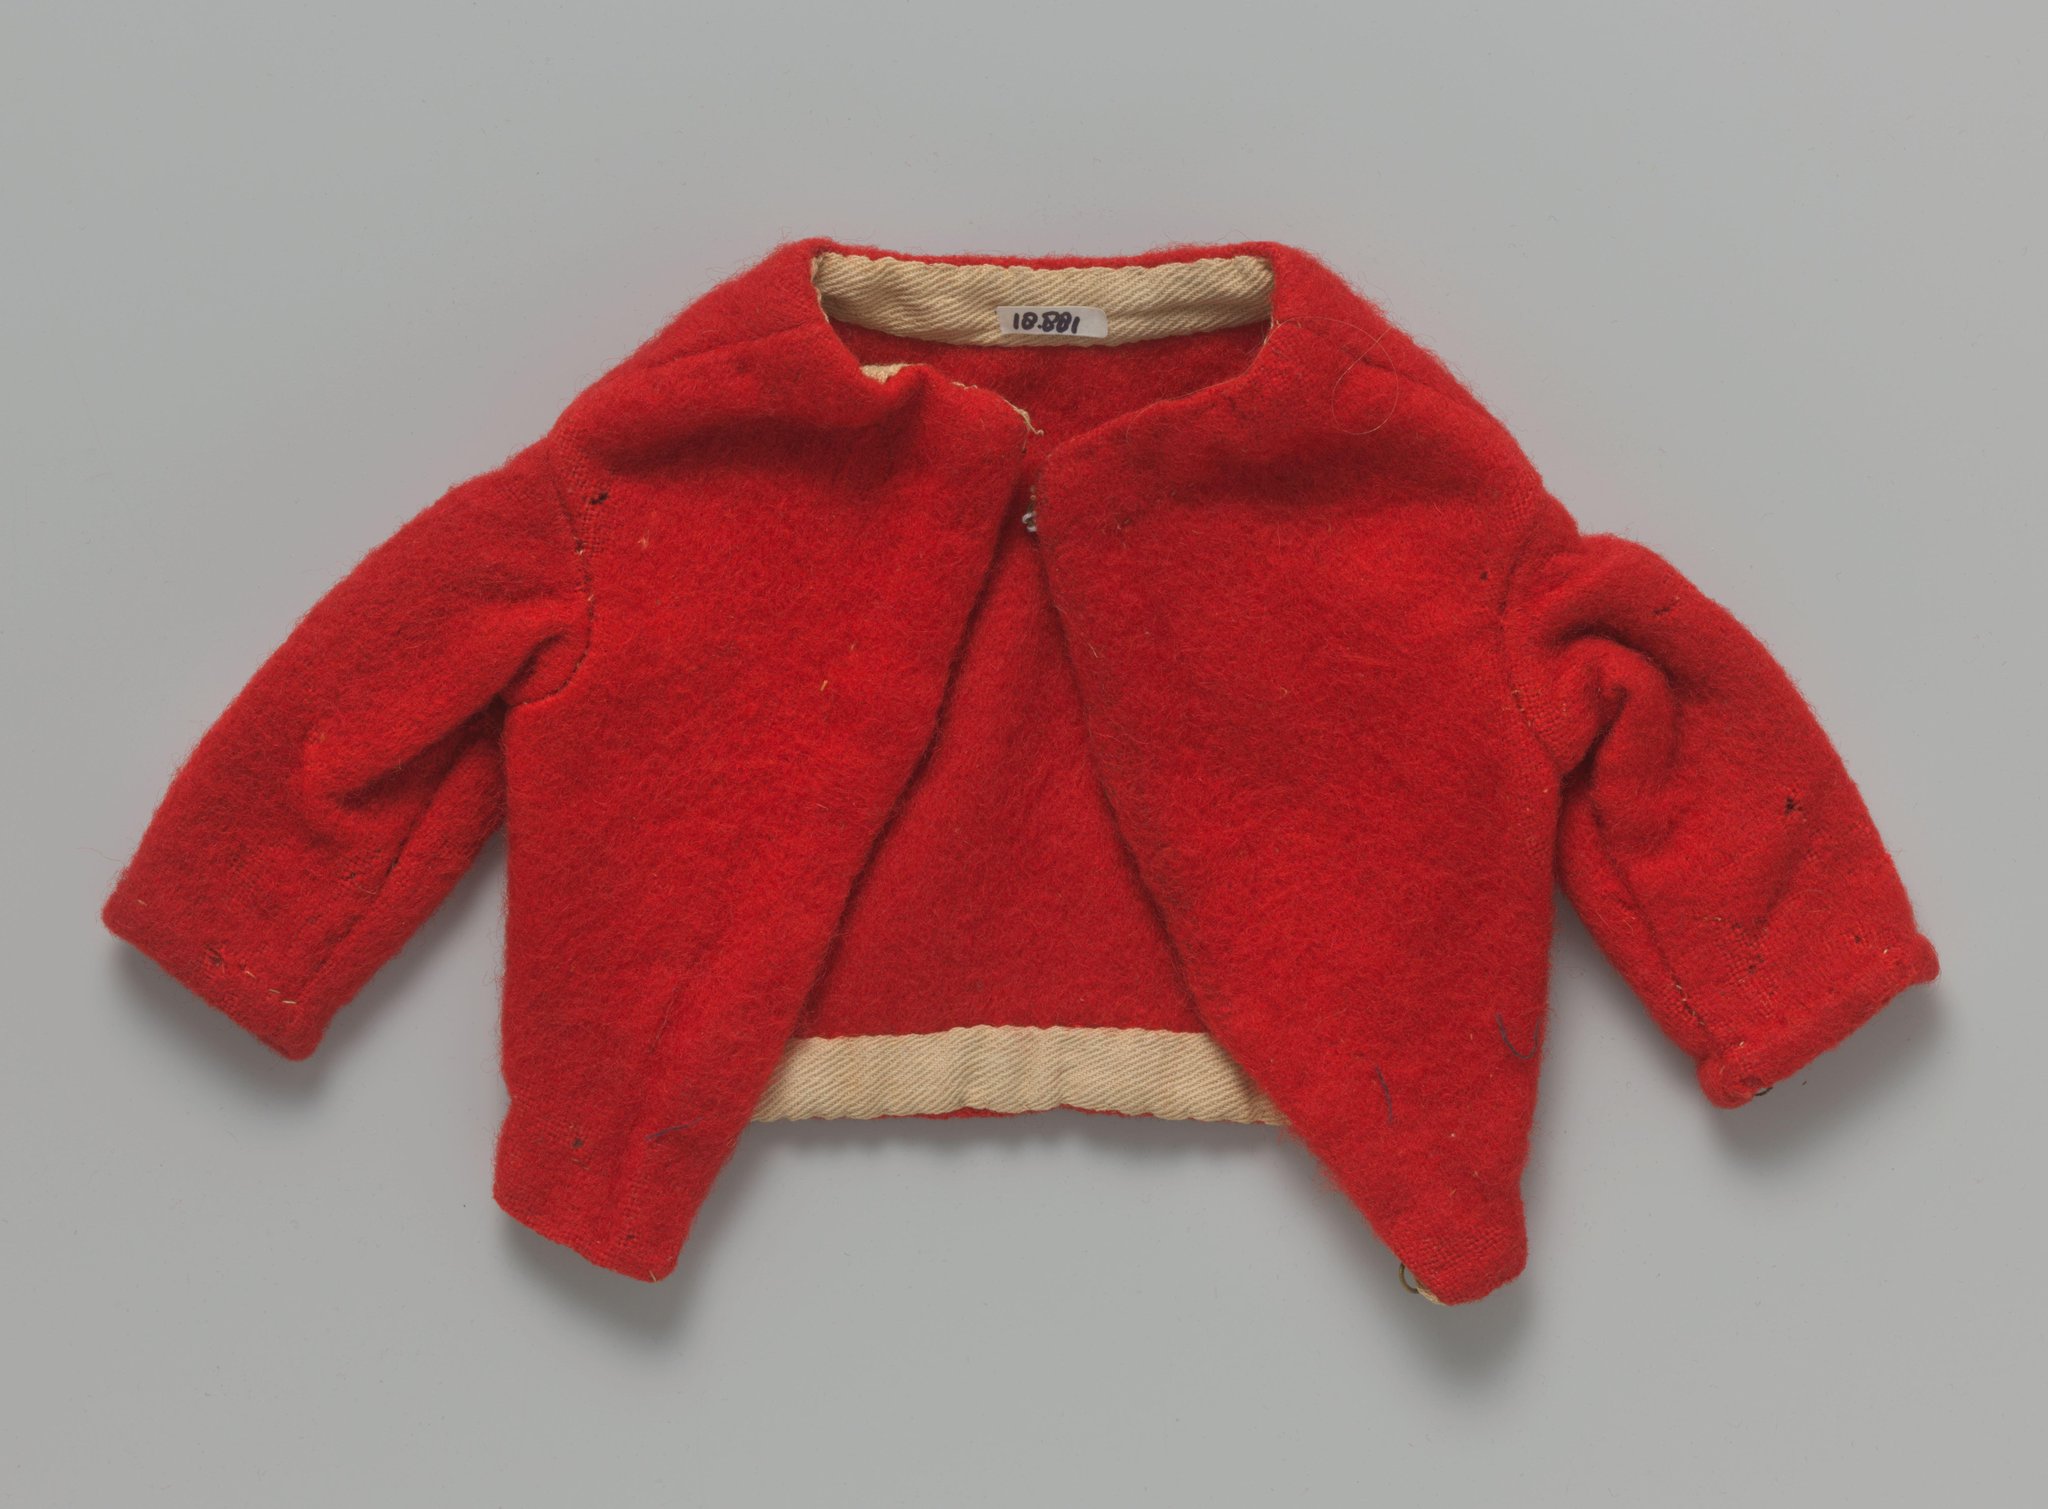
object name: clothing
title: Jas van rode wol met lange mouwen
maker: Anonymous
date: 1850-1900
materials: wool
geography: netherlands